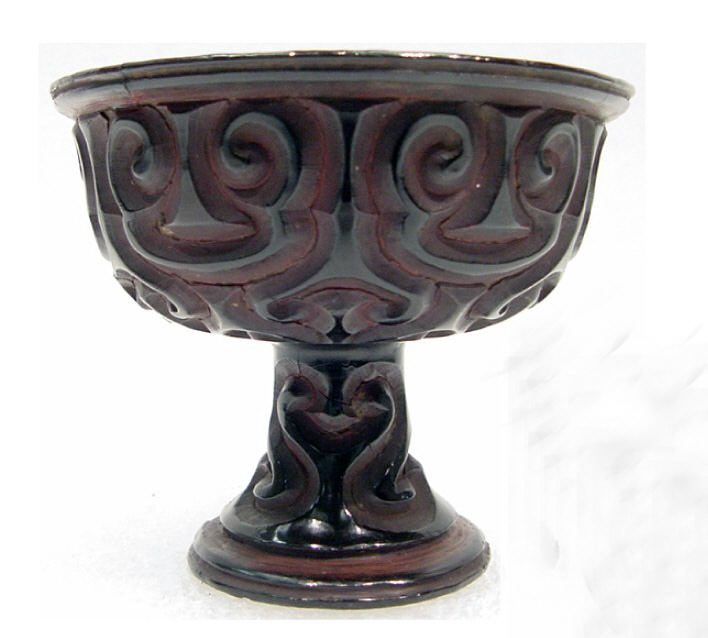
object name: stem cup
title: Stem Cup with Pommel Scroll Design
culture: chinese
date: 1201-1300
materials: lacquer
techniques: carving